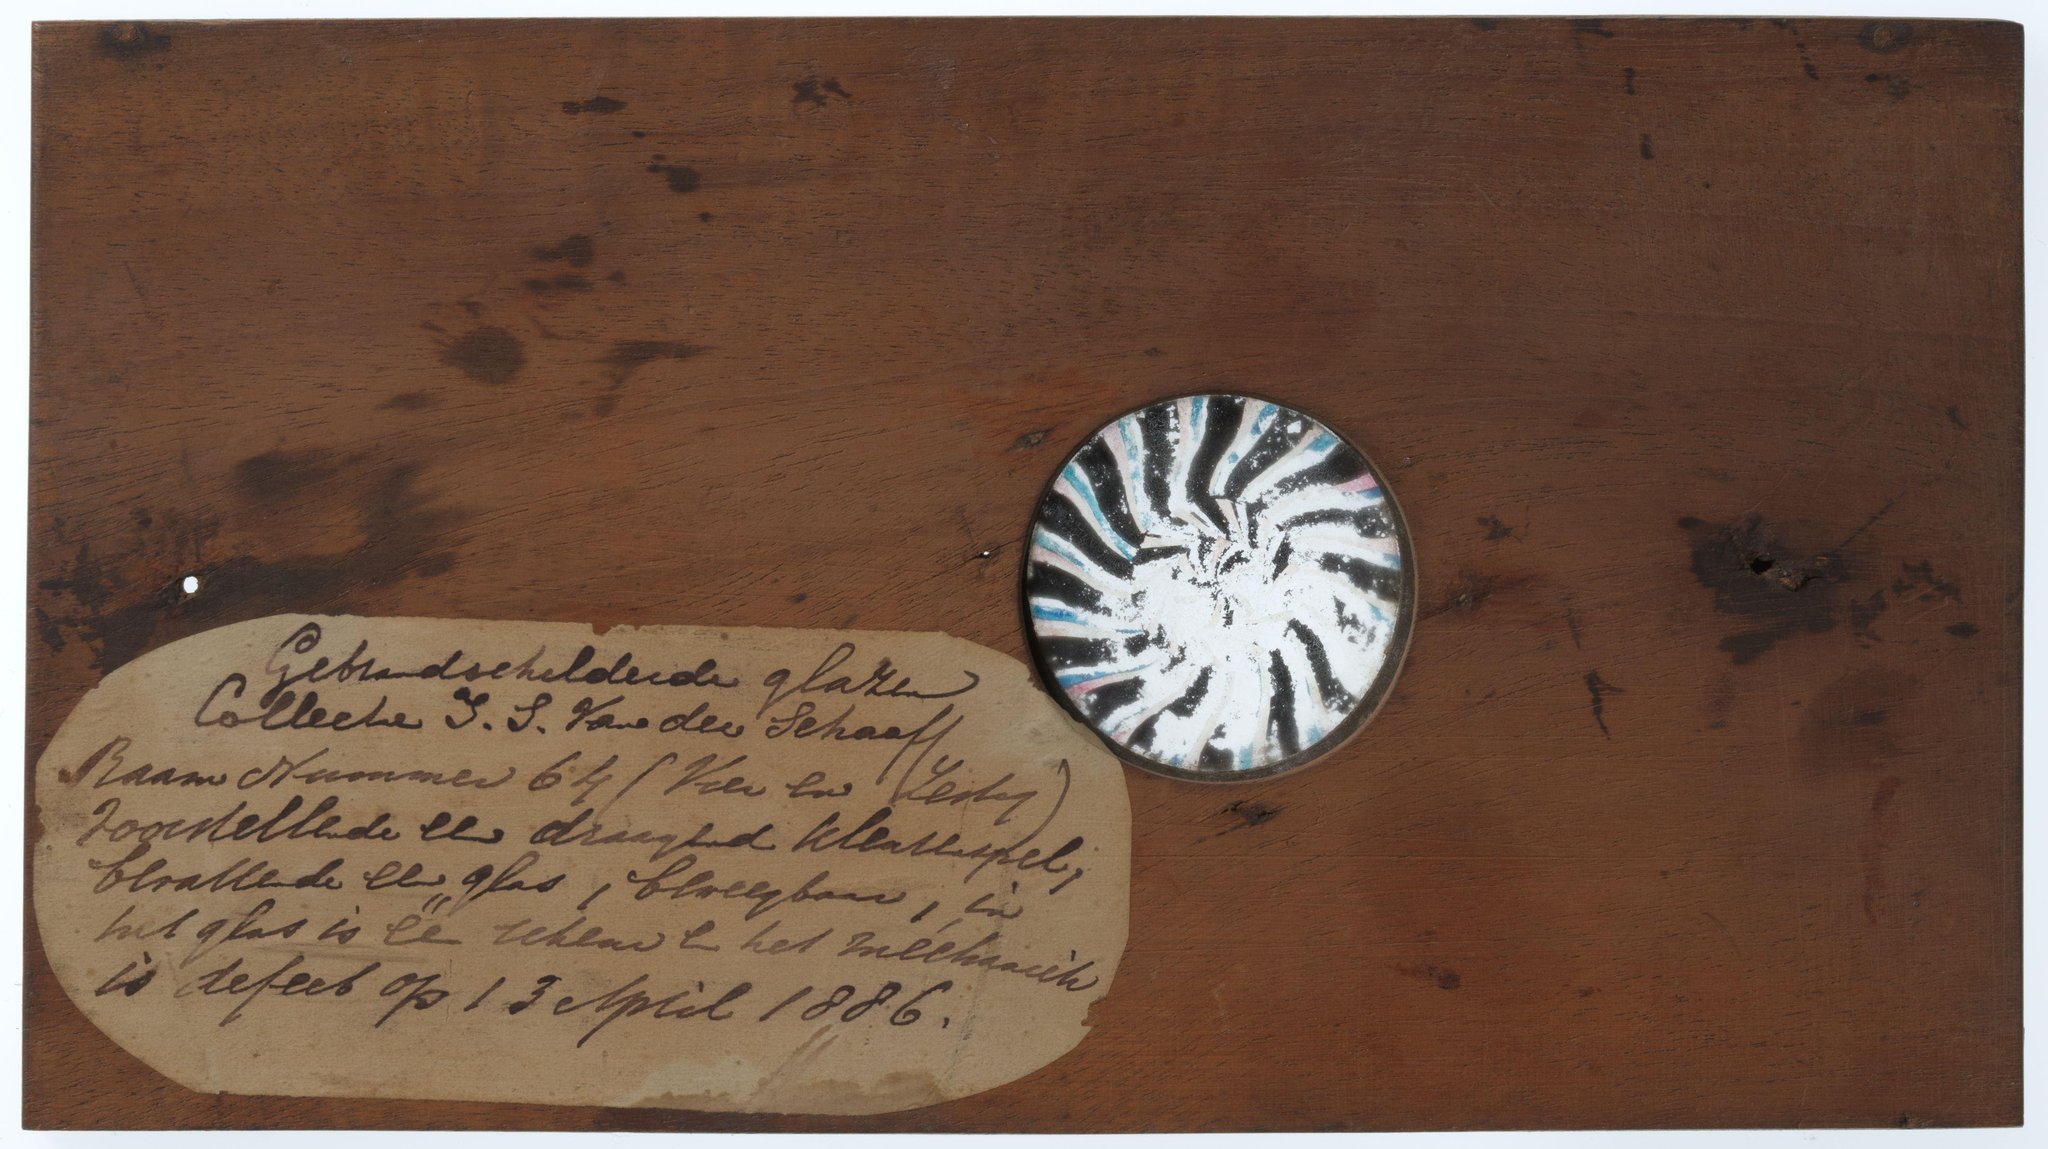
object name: lantern slide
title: chromatroop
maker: Anonymous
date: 1700-1830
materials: glass, wood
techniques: painted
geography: france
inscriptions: label: ‘'Gebrandschilderde glazen. Collectie J. I. Van der Schaaff Baarn. Nummer 64 (vier en zestig) bevattende één glas, voorstellende een draaiend klokkespel, waarachter beweegbaar glas. Het glas is defect op 13 april 1886'.’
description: Beweegbare toverlantaarnplaat, oorsp. een chromatroop, bestaande uit twee glaasjes met een kleurpatroon waarvan één draaibaar was, waardoor een spel van patronen en kleuren ontstond. Het bewegingsmechanisme en één van de glazen ontbreken.